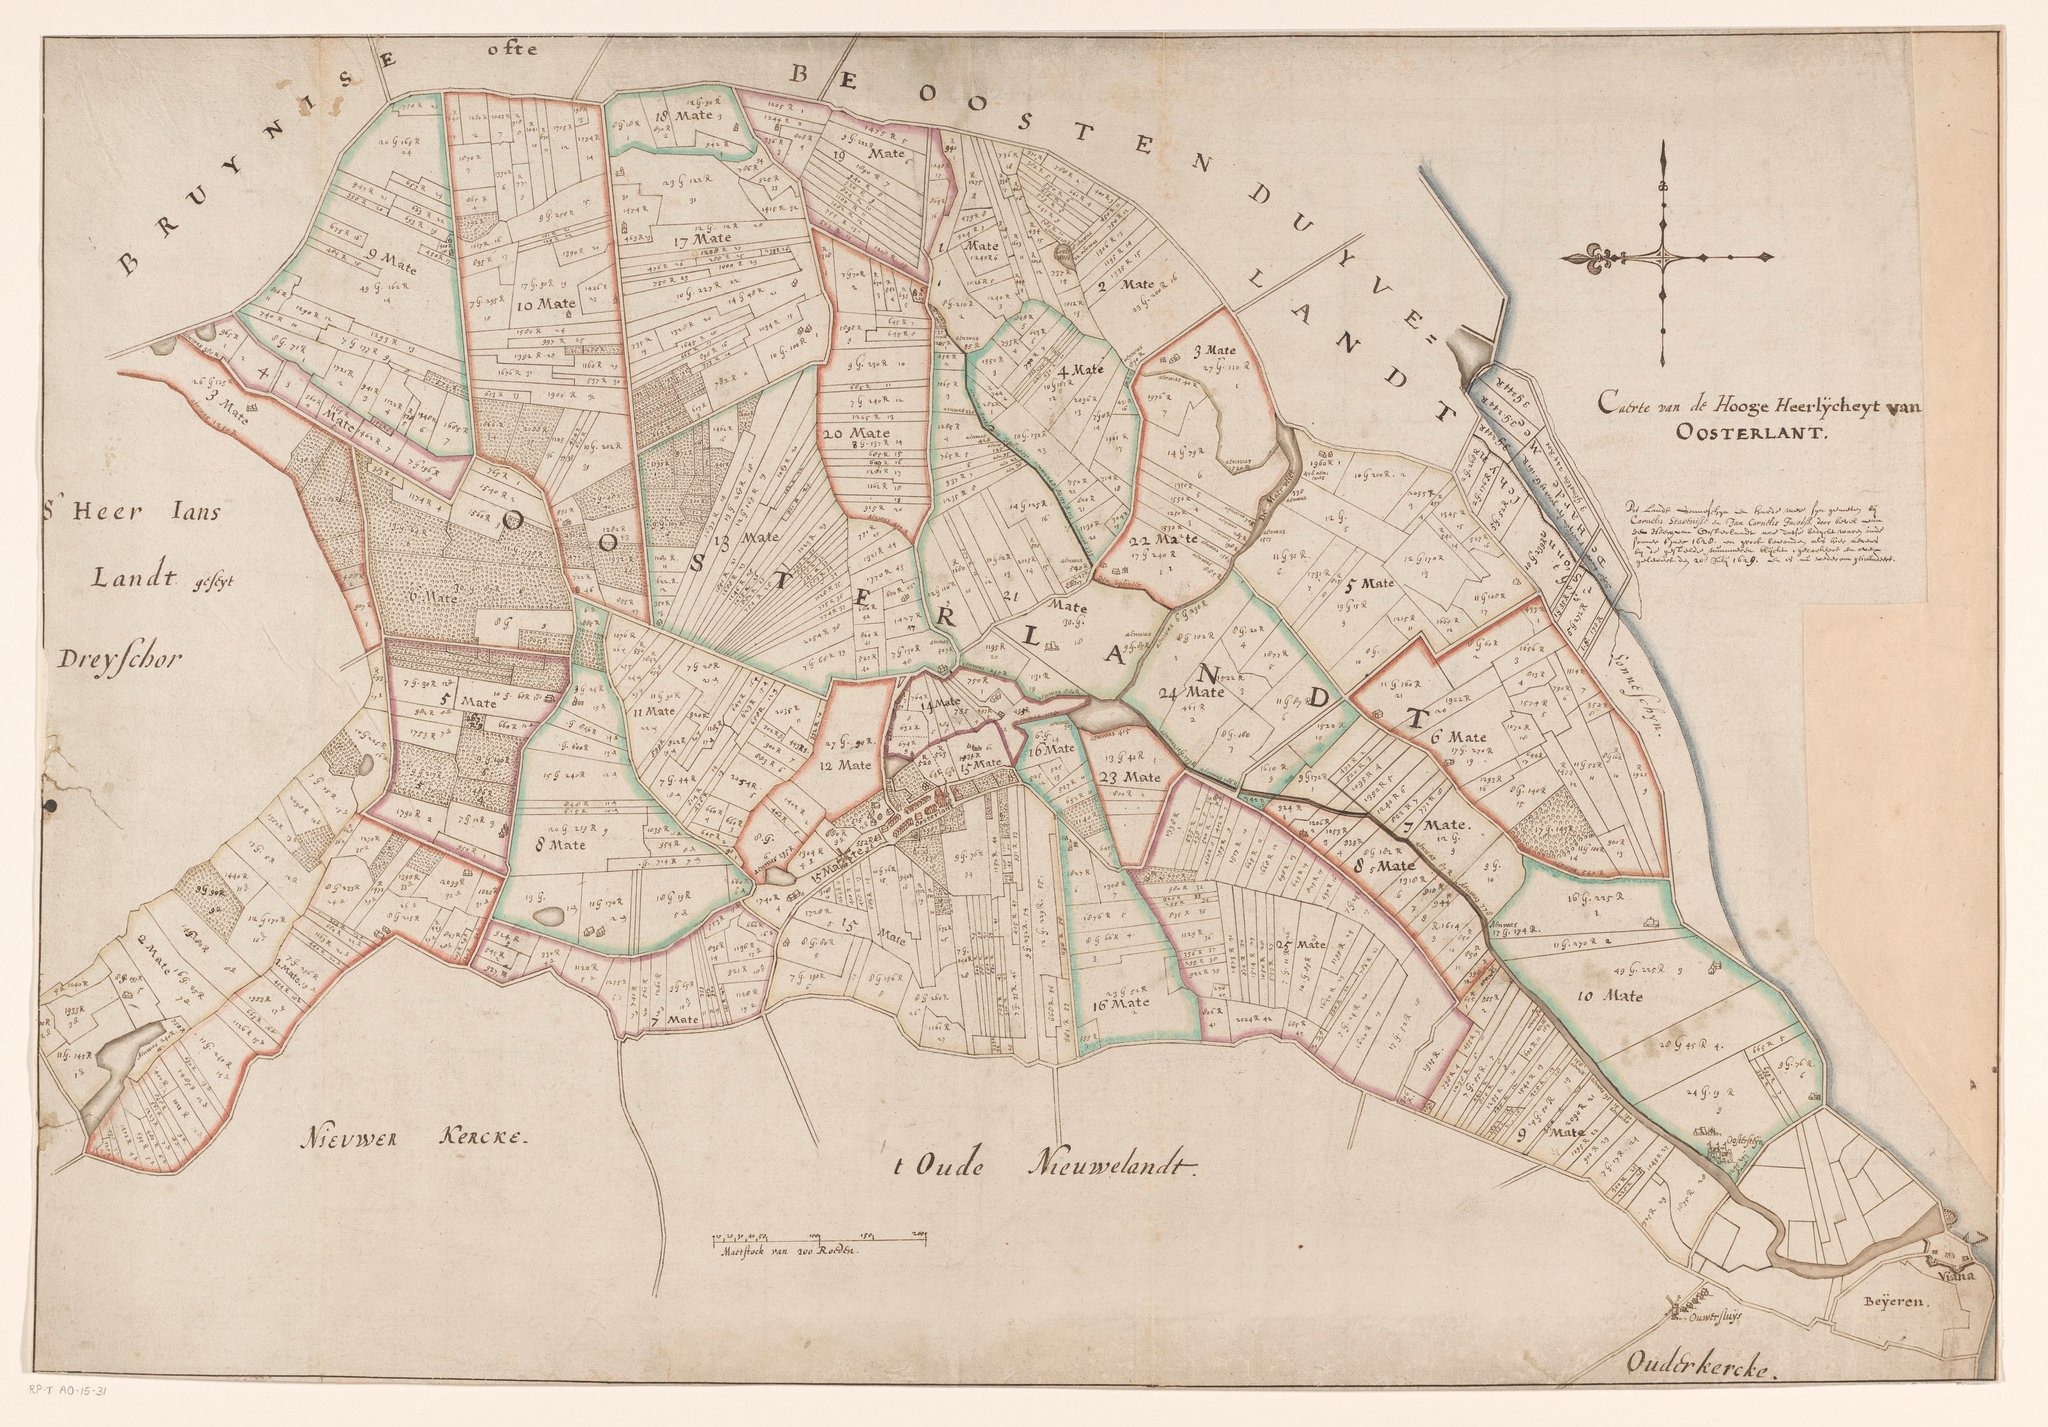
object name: map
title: Caerte van de hooge heerlijcheyt van Oosterlant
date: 1629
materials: ink, paper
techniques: brush, pen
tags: maps of separate countries or regions, polder, reclaimed land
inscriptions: inscription: ‘Dit landt Sonneschyn en Harde mee syn gemeten bij Cornelis Stavenisse en Jan Cornelis Jacobsz. door bevel van den Heeren van Oosterlandt nae datse bedyckt waren inde somer t' jaer 1628. en groot bevonden als hier nevens by de gestelde nummeren blijckt, gecarteert en over gelevert den 20e julij 1629. en is nu wederom geinundeert’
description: Kaart van de hoge heerlijkheid Oosterland, gelegen op Duiveland. Onder links van het midden een schaalstok: Maetstock van 200 roeden. Rechtsboven de titel en daaronder informatie over de kaart. Kaart gemaakt in opdracht van de heren van Oosterland naar aanleiding van de overstroming van de polders Zonneschijn en Hardemee in 1629, een jaar nadat deze polders bedijkt waren en vlak nadat het gebied door landmeters Cornelis Stavenisse en Jan Cornelis Jacobsz. was opgemeten en gekarteerd.